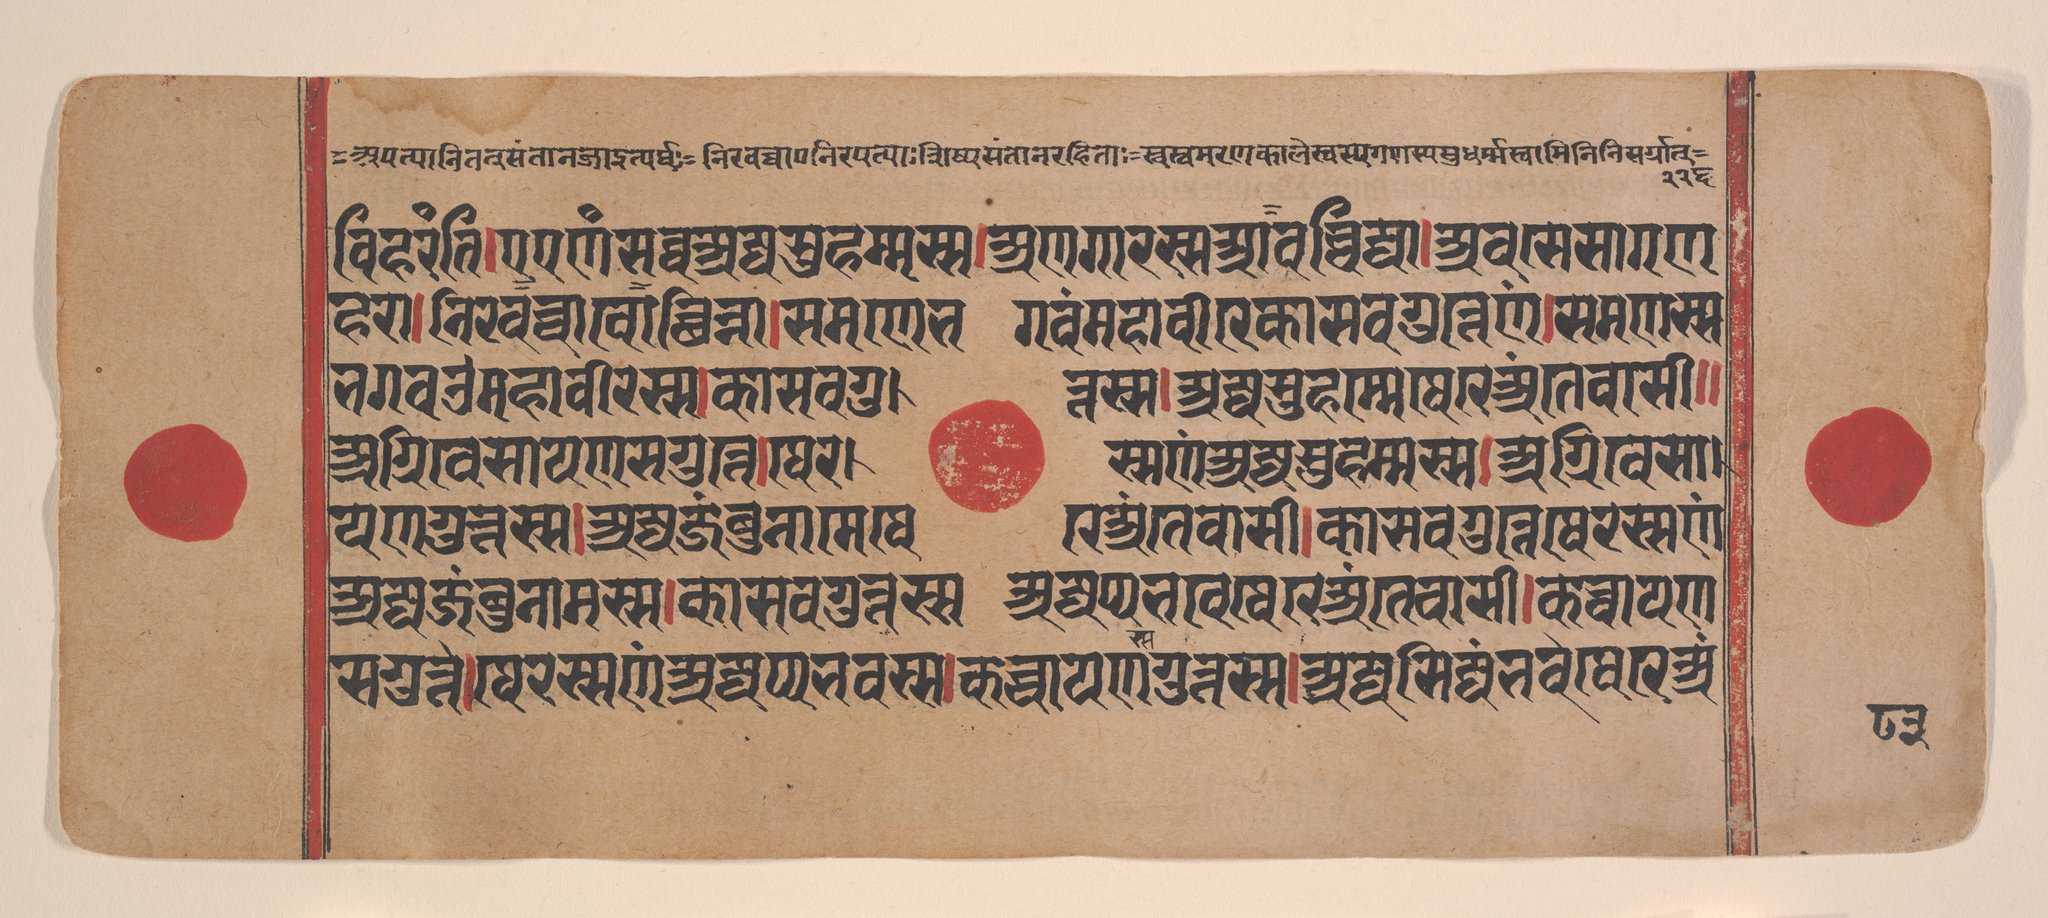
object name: folio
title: Page from a Dispersed Kalpa Sutra (Jain Book of Rituals)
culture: indian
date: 1401-1500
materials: gold, ink, paper, watercolor